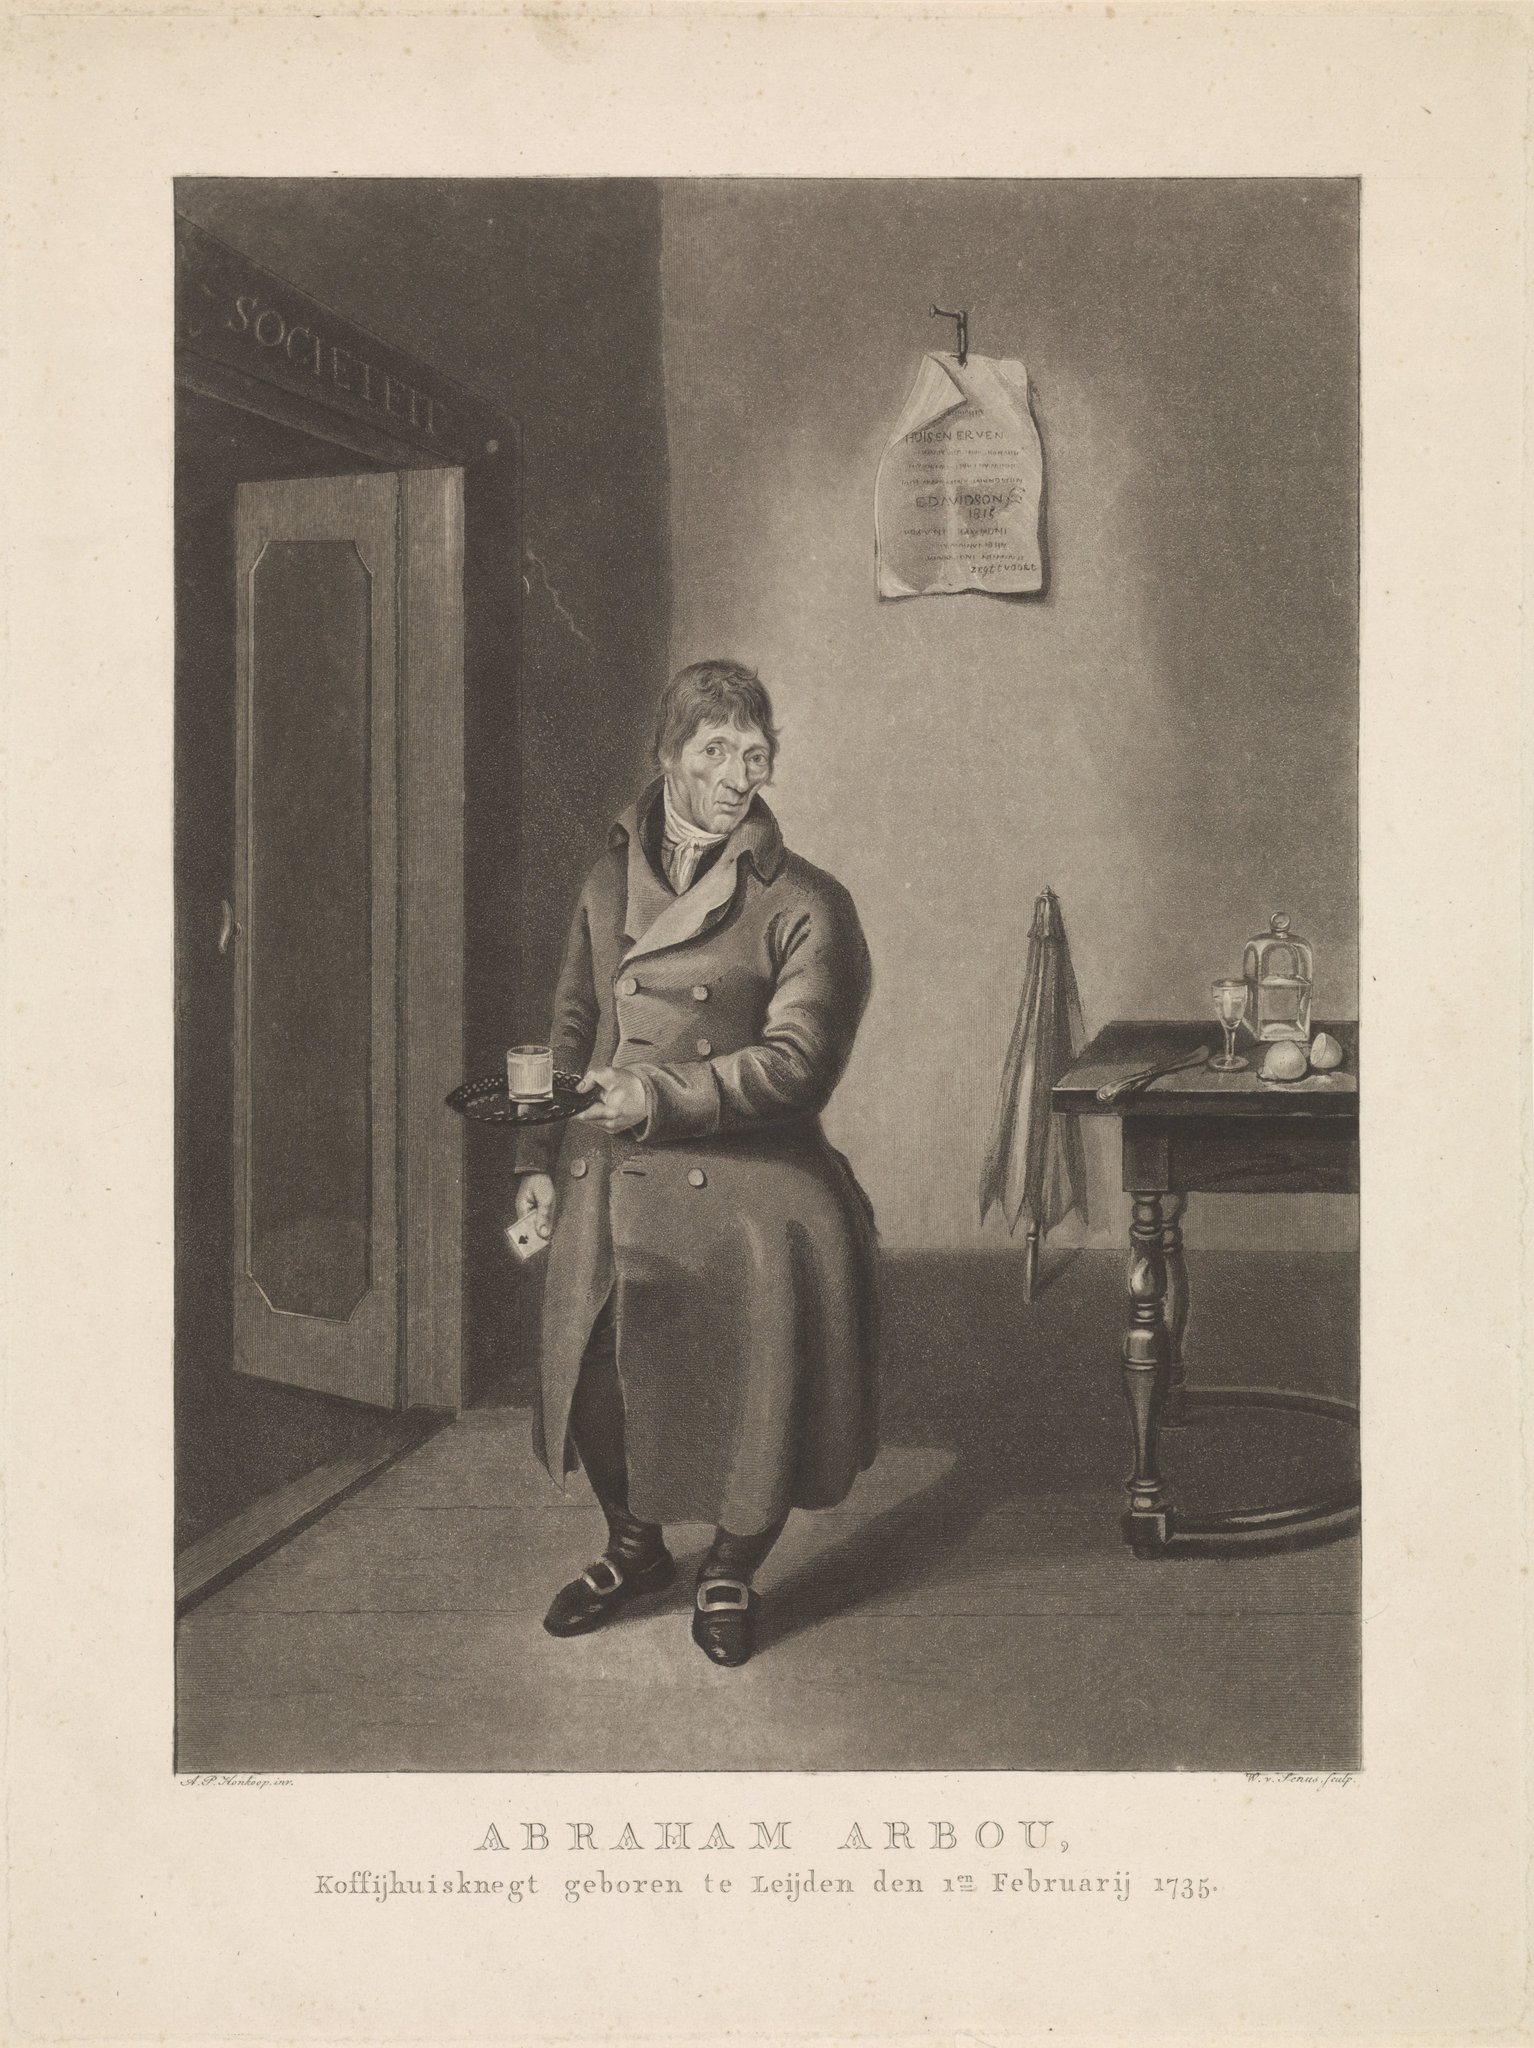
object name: print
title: Portret van Abraham Arbou, 1815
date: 1815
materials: paper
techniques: aquatint, etching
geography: netherlands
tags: leiden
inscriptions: collector's mark: Lugt 2228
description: Portret van Abraham Arbou, 50 jaar koffieknecht bij de kastelein Hoogstraten in de Studentensociëteit te Leiden. Knecht staande met een dienblad waarop een glas en met een spel kaarten in de andere hand. Boven de deur staat: Societeit.